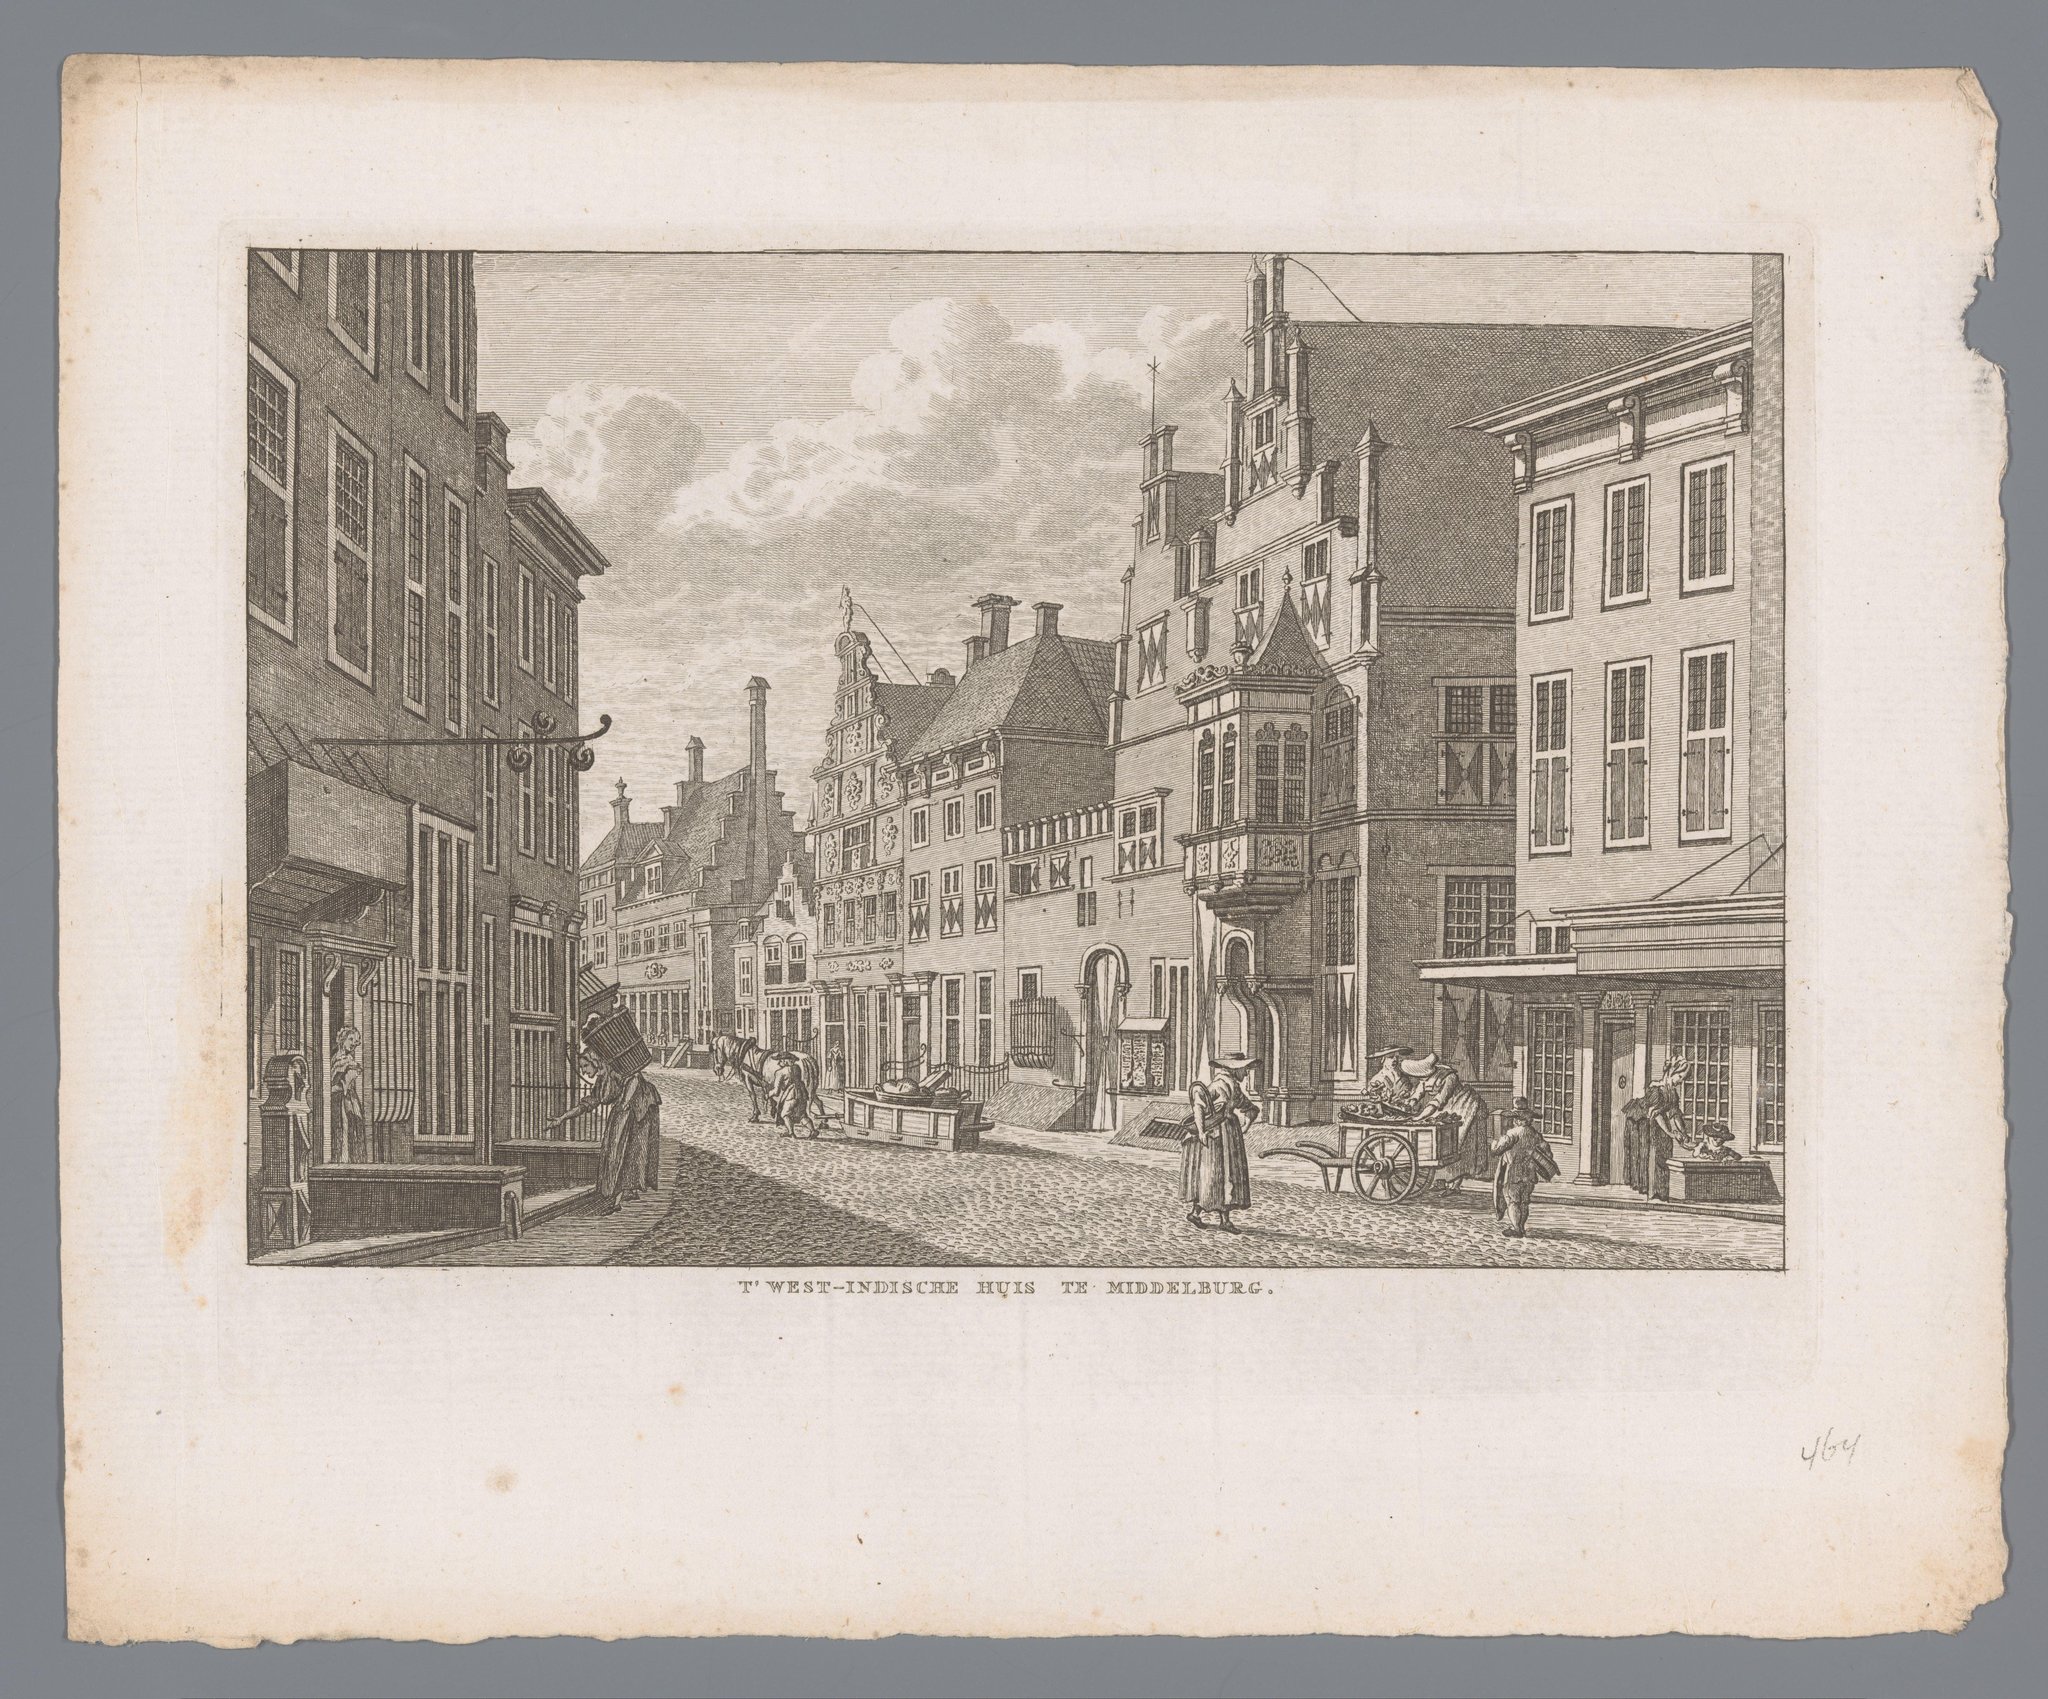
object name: print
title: T' West-Indische Huis te Middelburg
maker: carel frederik bendorp (i)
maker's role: print maker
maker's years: 1736-1814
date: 1786-1792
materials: paper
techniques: etching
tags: trade-company, street (+ city(-scape) with figures, staffage)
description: Prent uit: Vaderlandsche gezichten, of afbeeldingen van den tegenwoordigen staat der Vereenigde Nederlanden (…). Amsterdam: Hendrik Gartman, Willem Vermandel en Jan Willem Smit, 1786-1792. Uitgegeven in afleveringen met ieder een eigen bifolium en inhoudsopgave. Alle prenten in deze publicatie zijn gegraveerd door Carel Frederik Bendorp (I) en, in de meeste gevallen, gebaseerd op tekeningen van Jan Bulthuis.